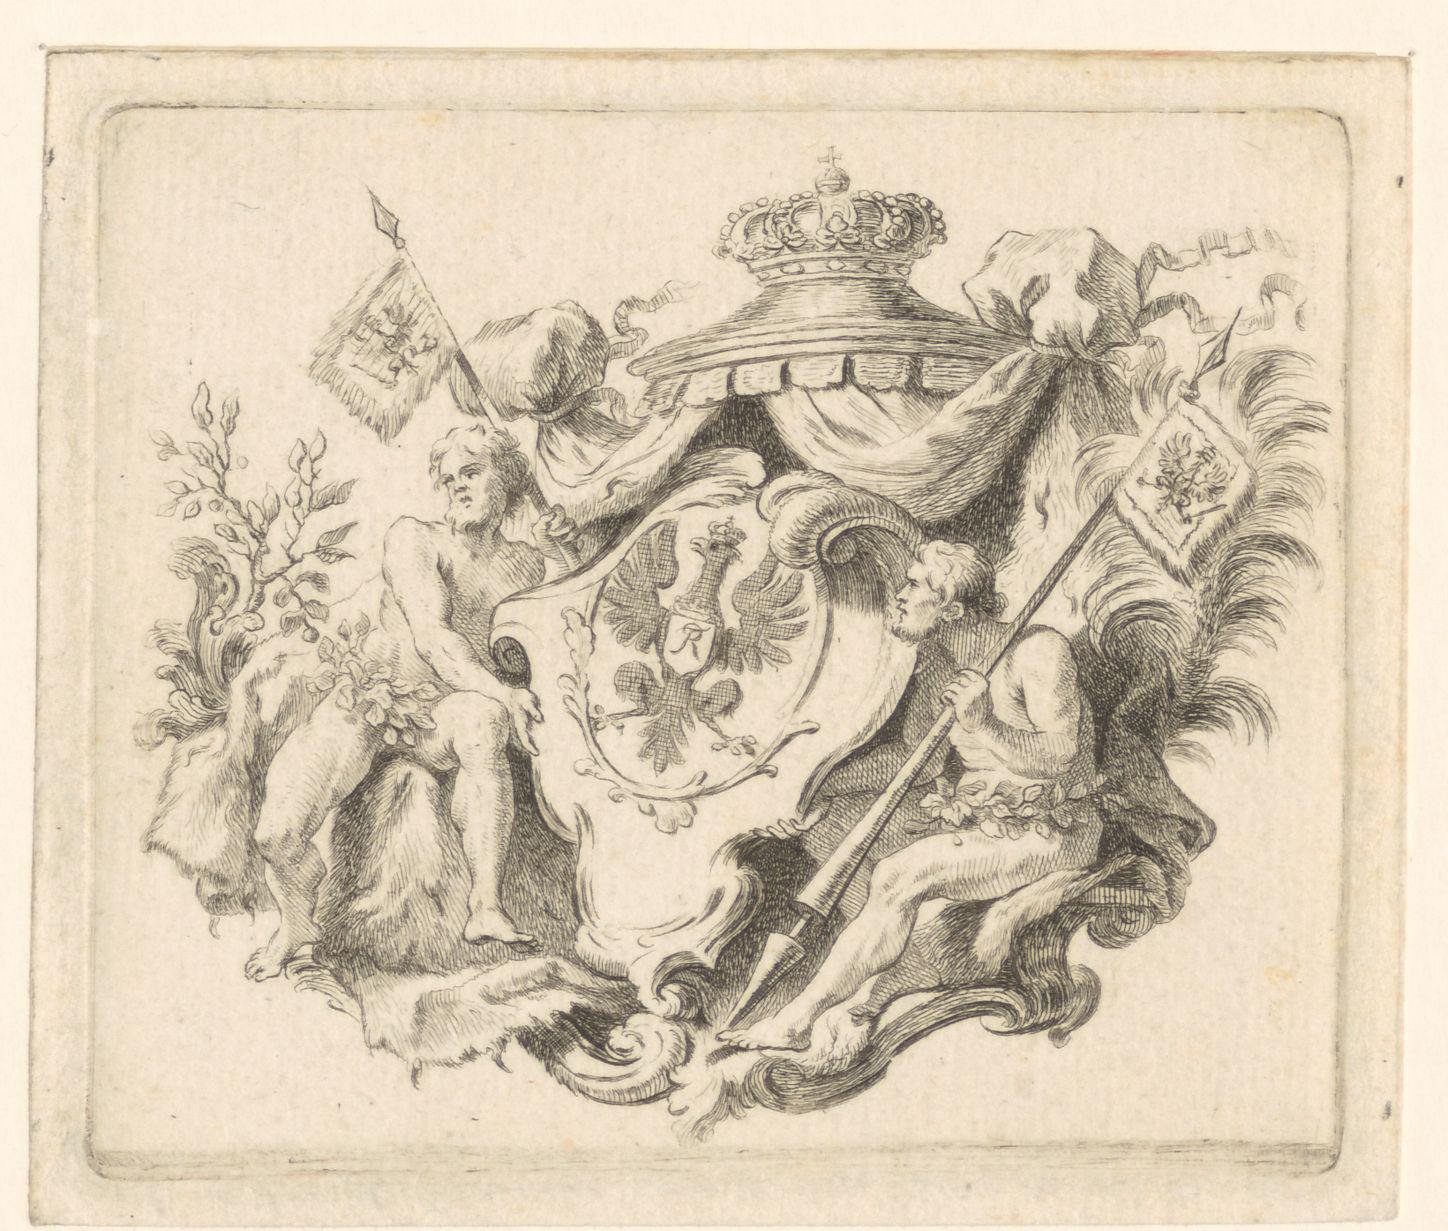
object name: book illustration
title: Vignet met het wapen van Pruisen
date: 1751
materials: paper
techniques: etching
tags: vignette, symbols of particular nations, states, districts, etc.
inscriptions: collector's mark: Lugt 240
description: Prent ook gebruikt in: Frederik de Grote. Mémoires pour servir a l'histoire de la maison de Brandebourg. Sanssouci, Frederik de Grote, 1751.